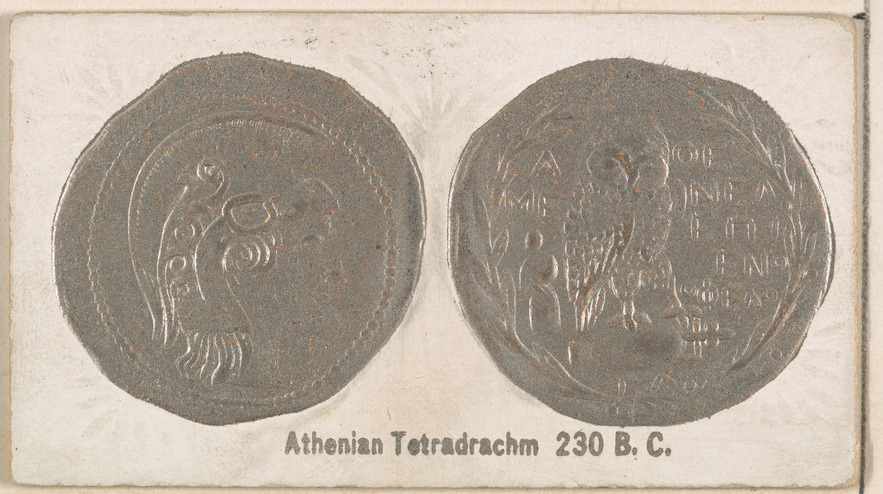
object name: print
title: Athenian Tetradrachm, 230 B.C., from the Ancient Coins series (N180) issued by Wm. S. Kimball & Co.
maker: william s. kimball & company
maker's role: publisher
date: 1888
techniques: color lithograph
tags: owls,coins